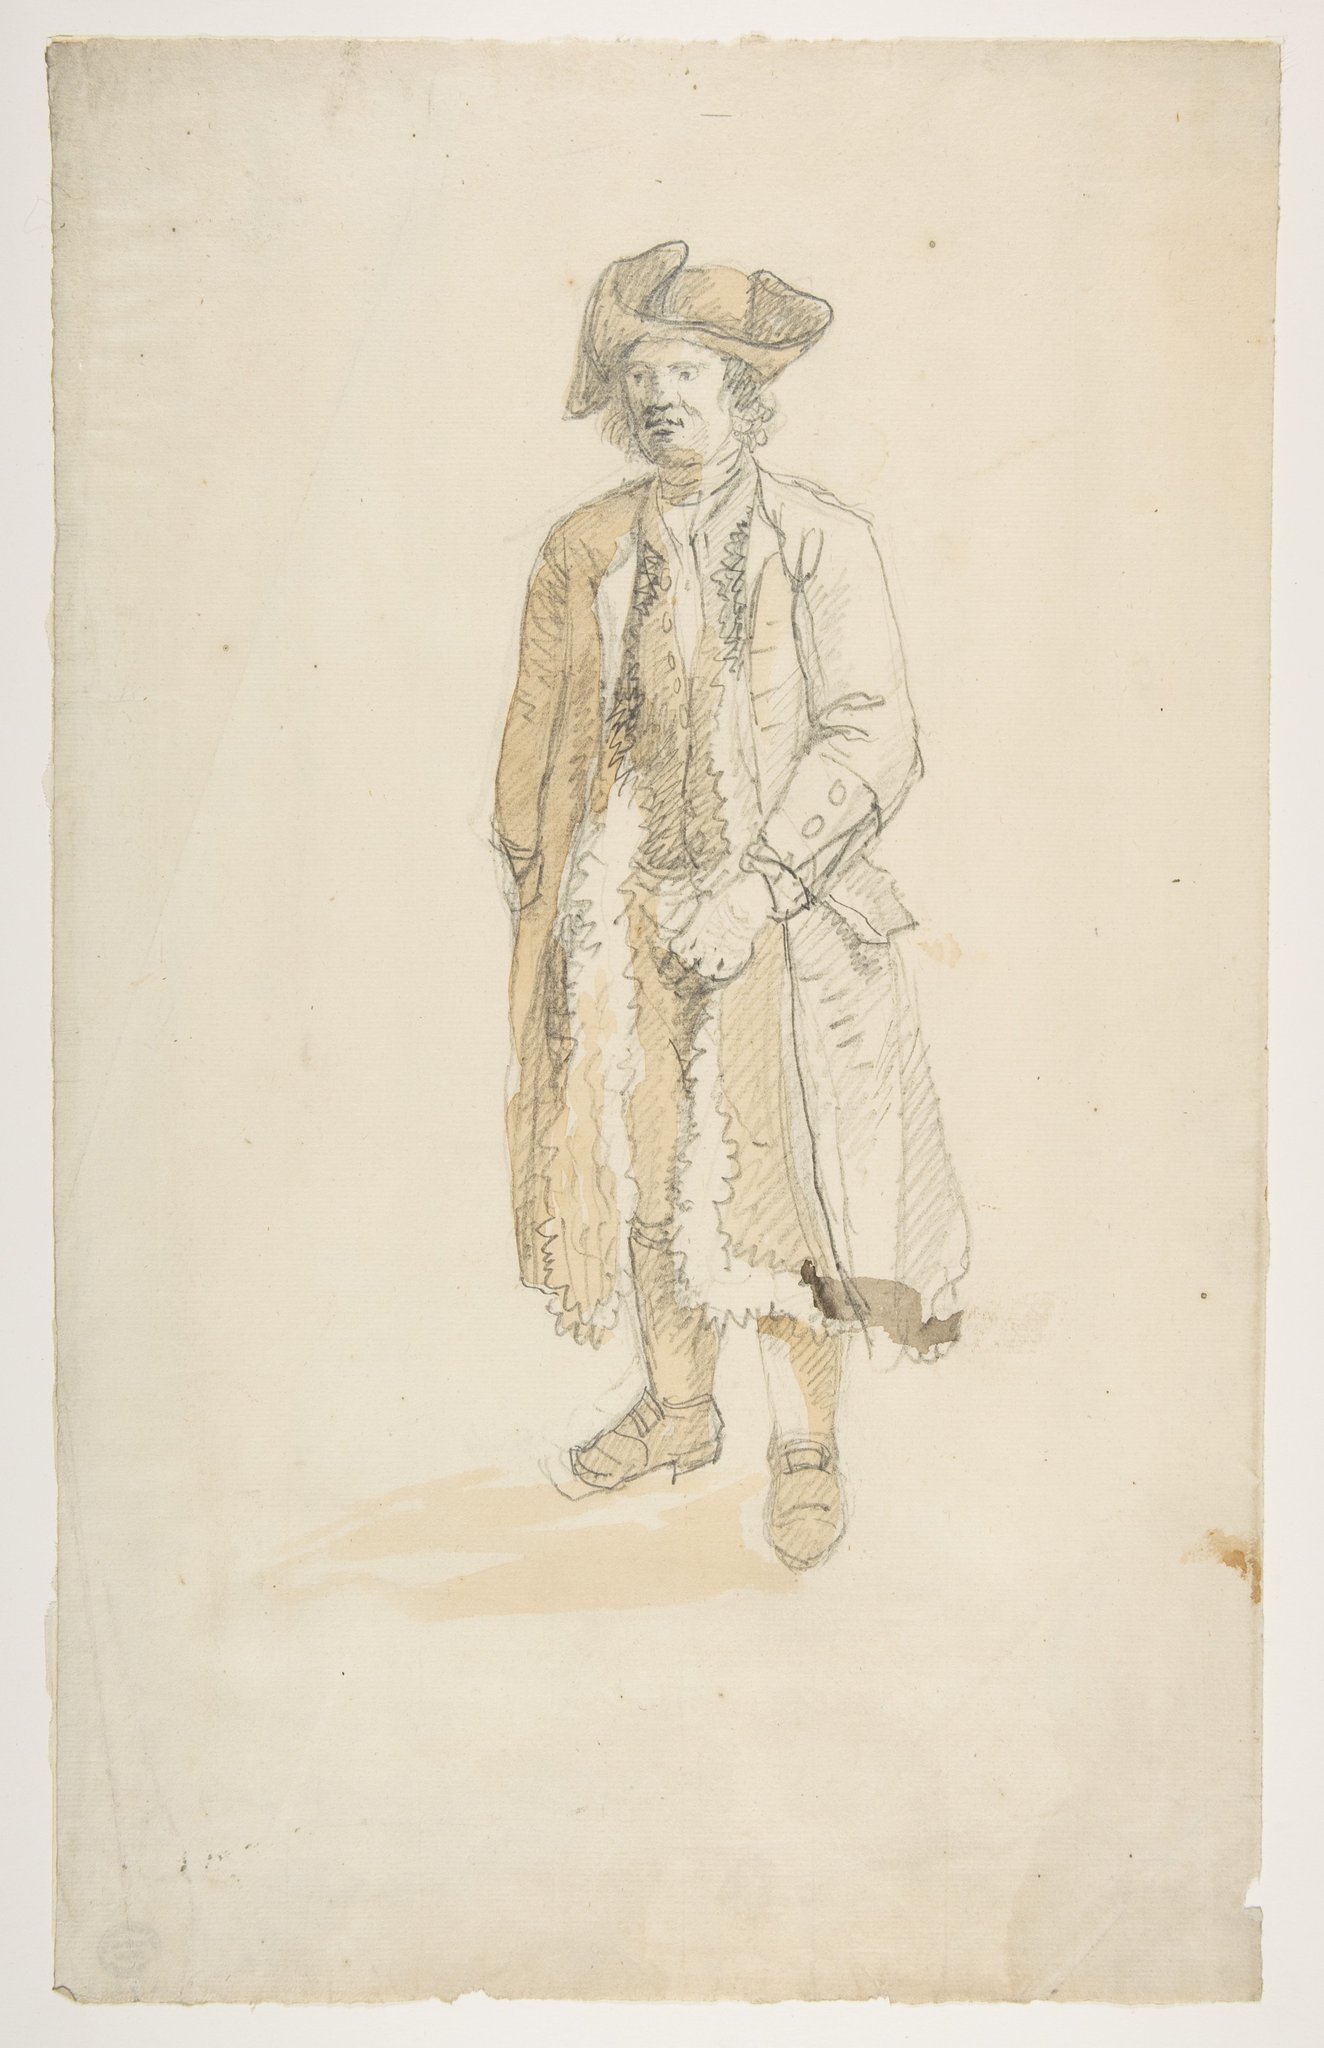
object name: drawing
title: Man Standing in Three-Quarter View Facing Left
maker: francesco zuccarelli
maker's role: artist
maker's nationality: italian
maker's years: 1702-1788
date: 1702-1788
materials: graphite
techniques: brush, wash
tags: men